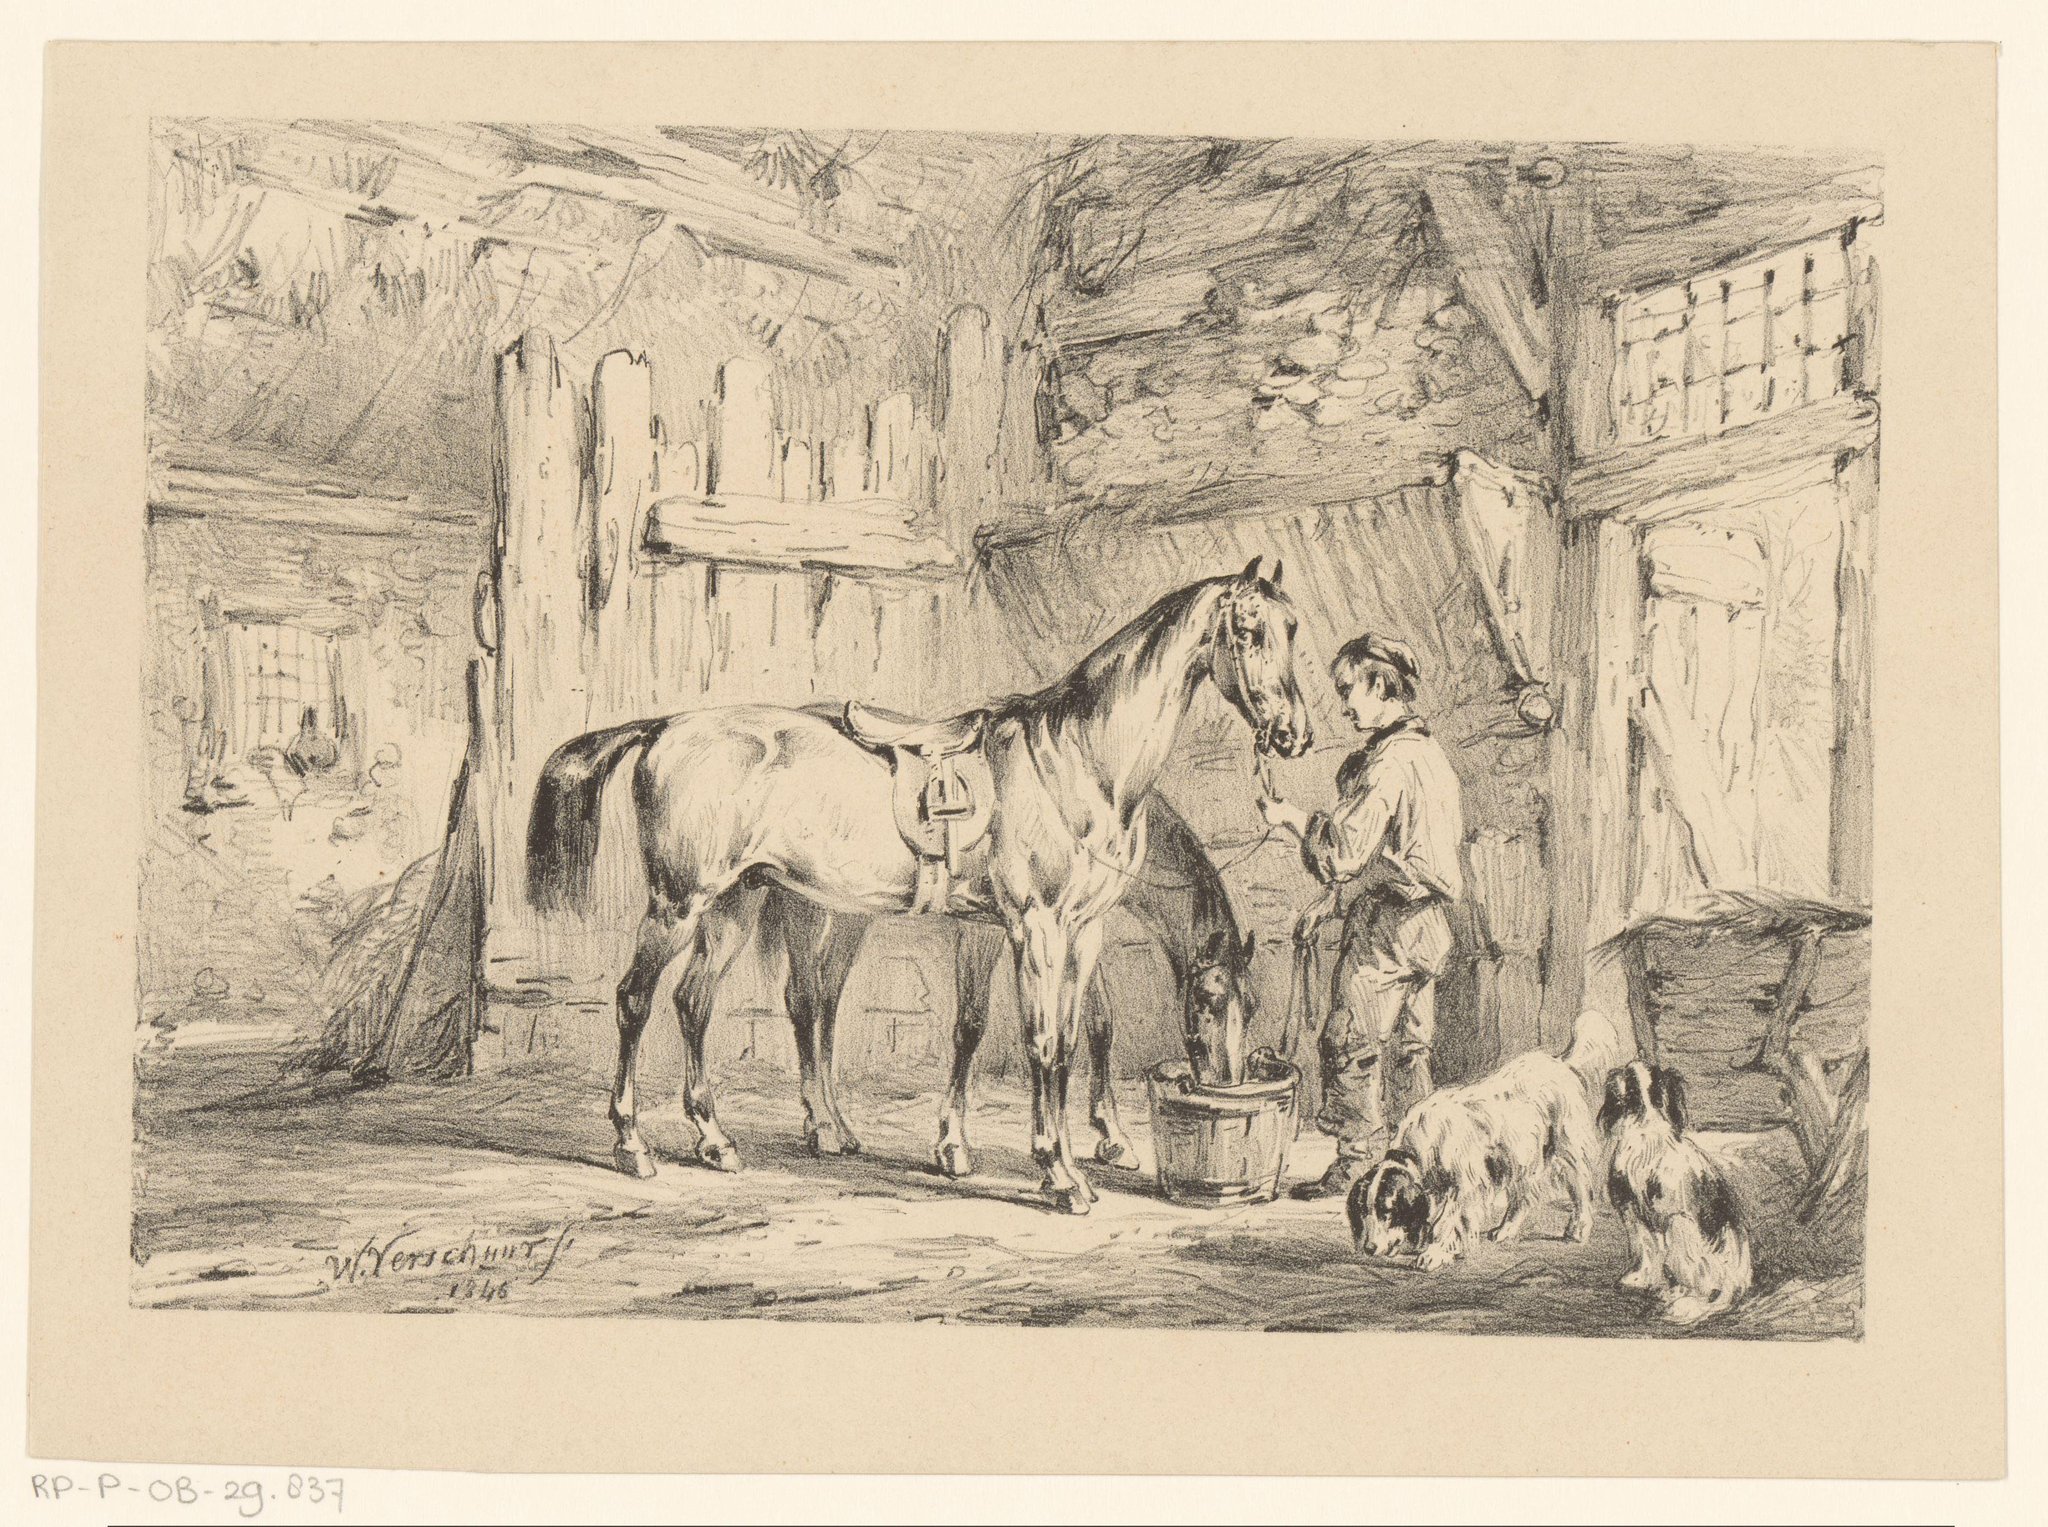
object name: print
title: Twee paarden met knecht in de stal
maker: wouter verschuur (1812-1874)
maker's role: draughtsman, painter, print maker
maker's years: 1812-1874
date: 1846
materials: paper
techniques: lithograph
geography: netherlands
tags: barn, horse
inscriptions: collector's mark: Lugt 2228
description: Twee paarden, twee honden en een knecht in een stal.